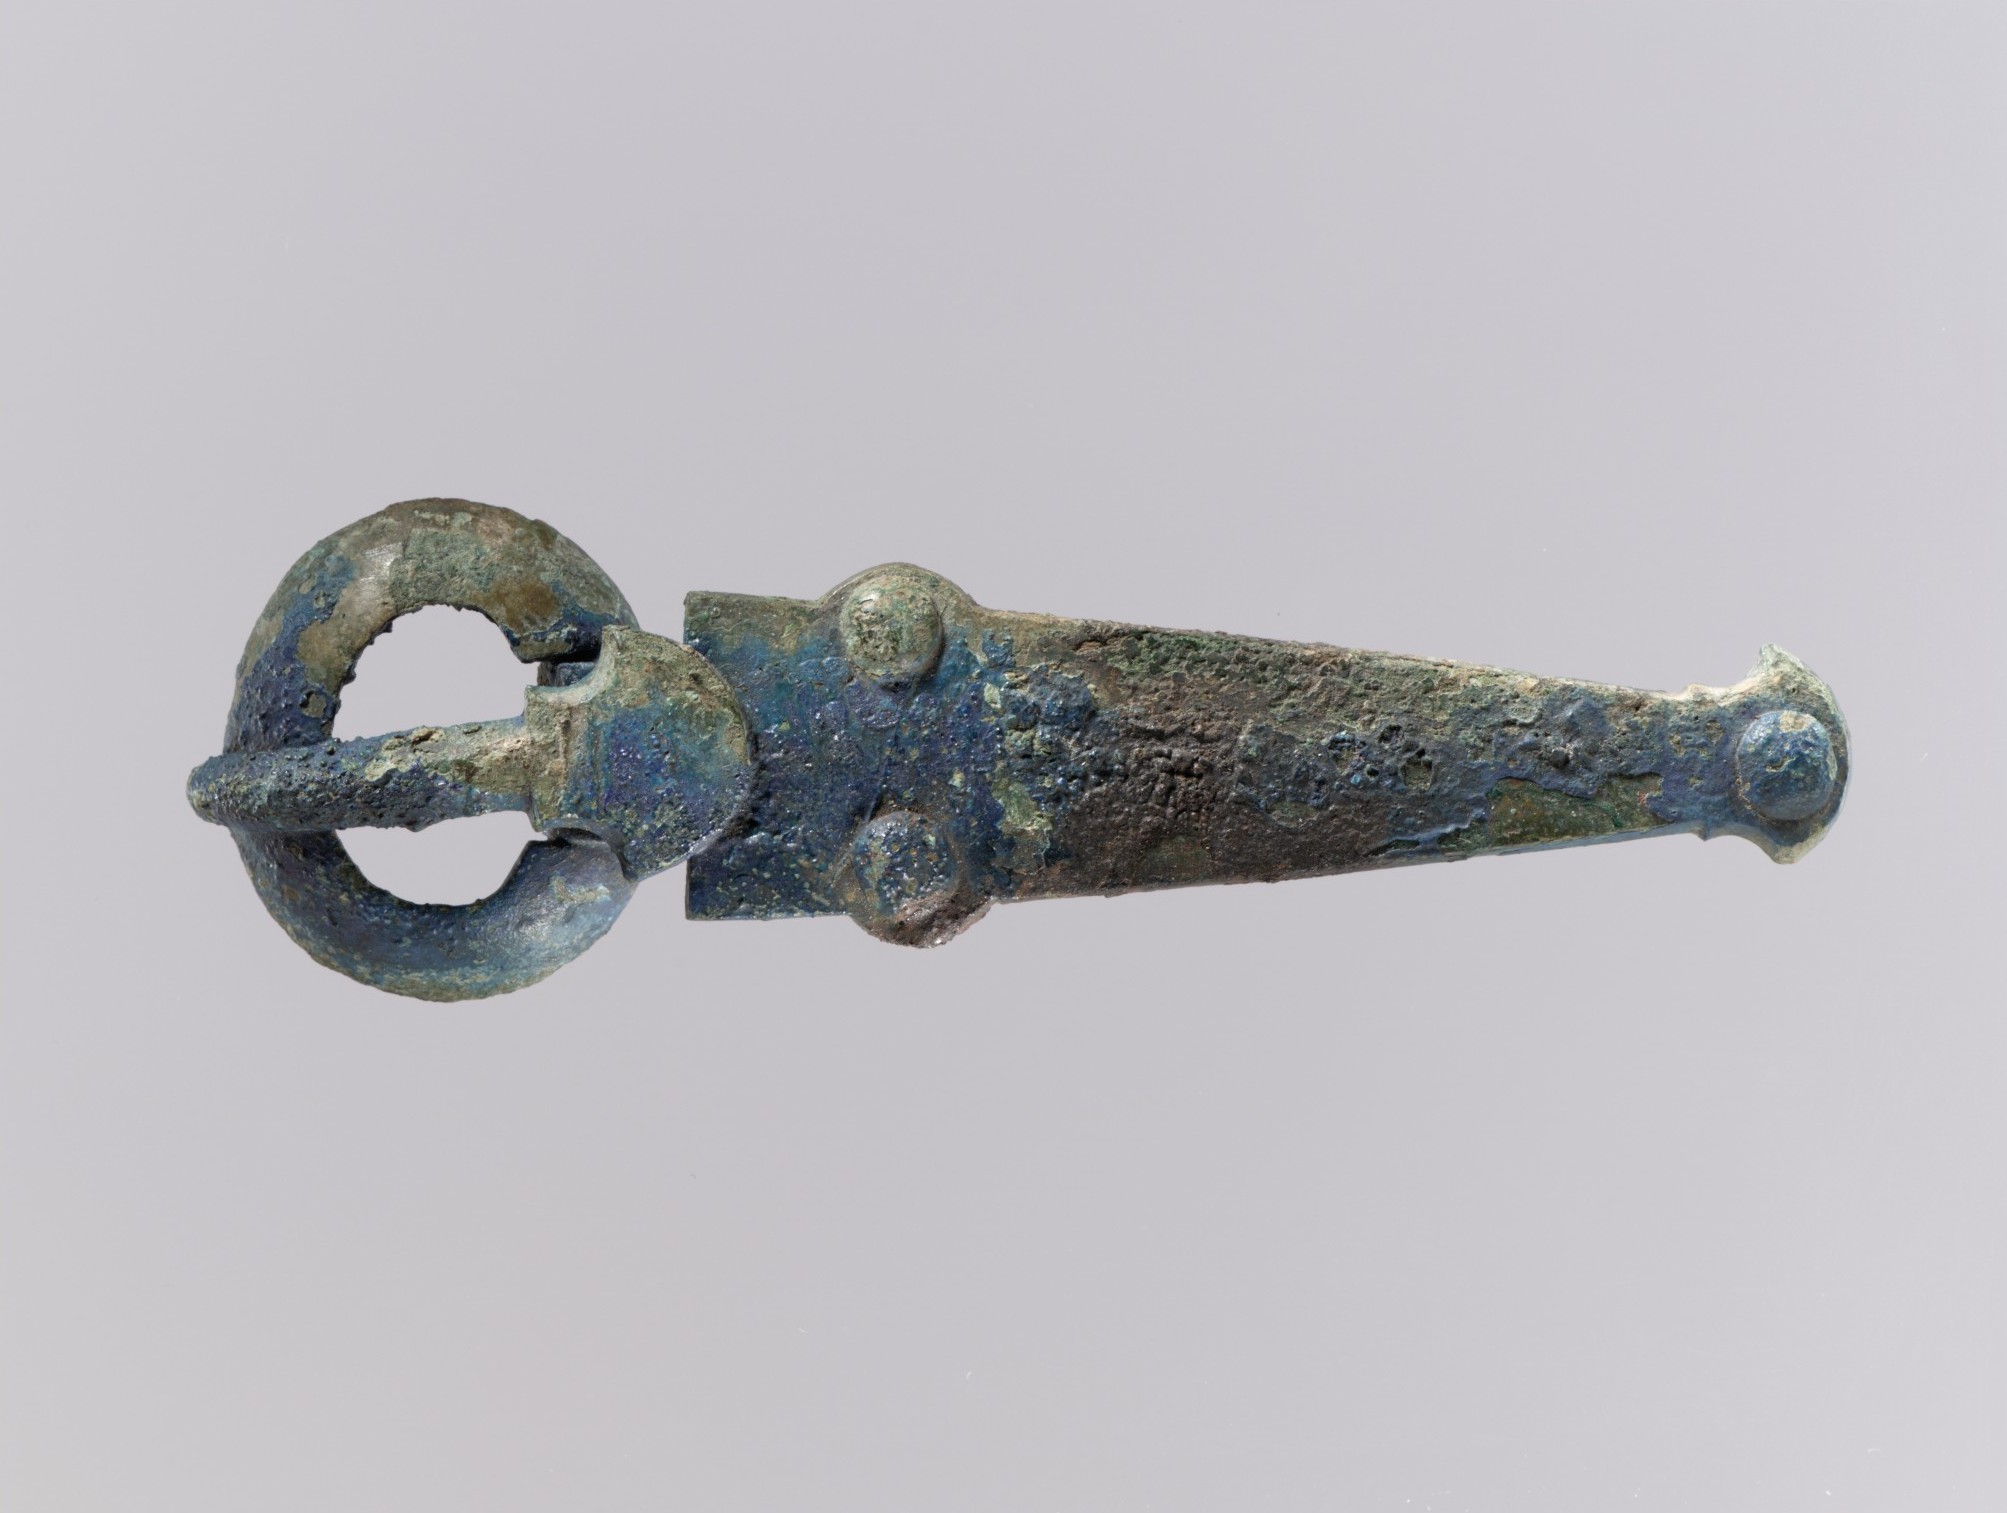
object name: buckle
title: Elongated Buckle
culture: frankish or langobardic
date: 601-700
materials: copper alloy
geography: germany